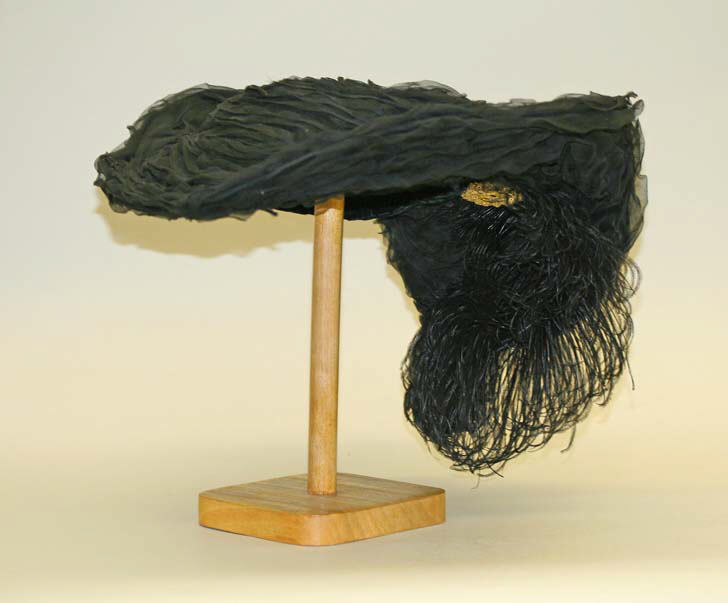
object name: hat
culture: american or european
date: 1892